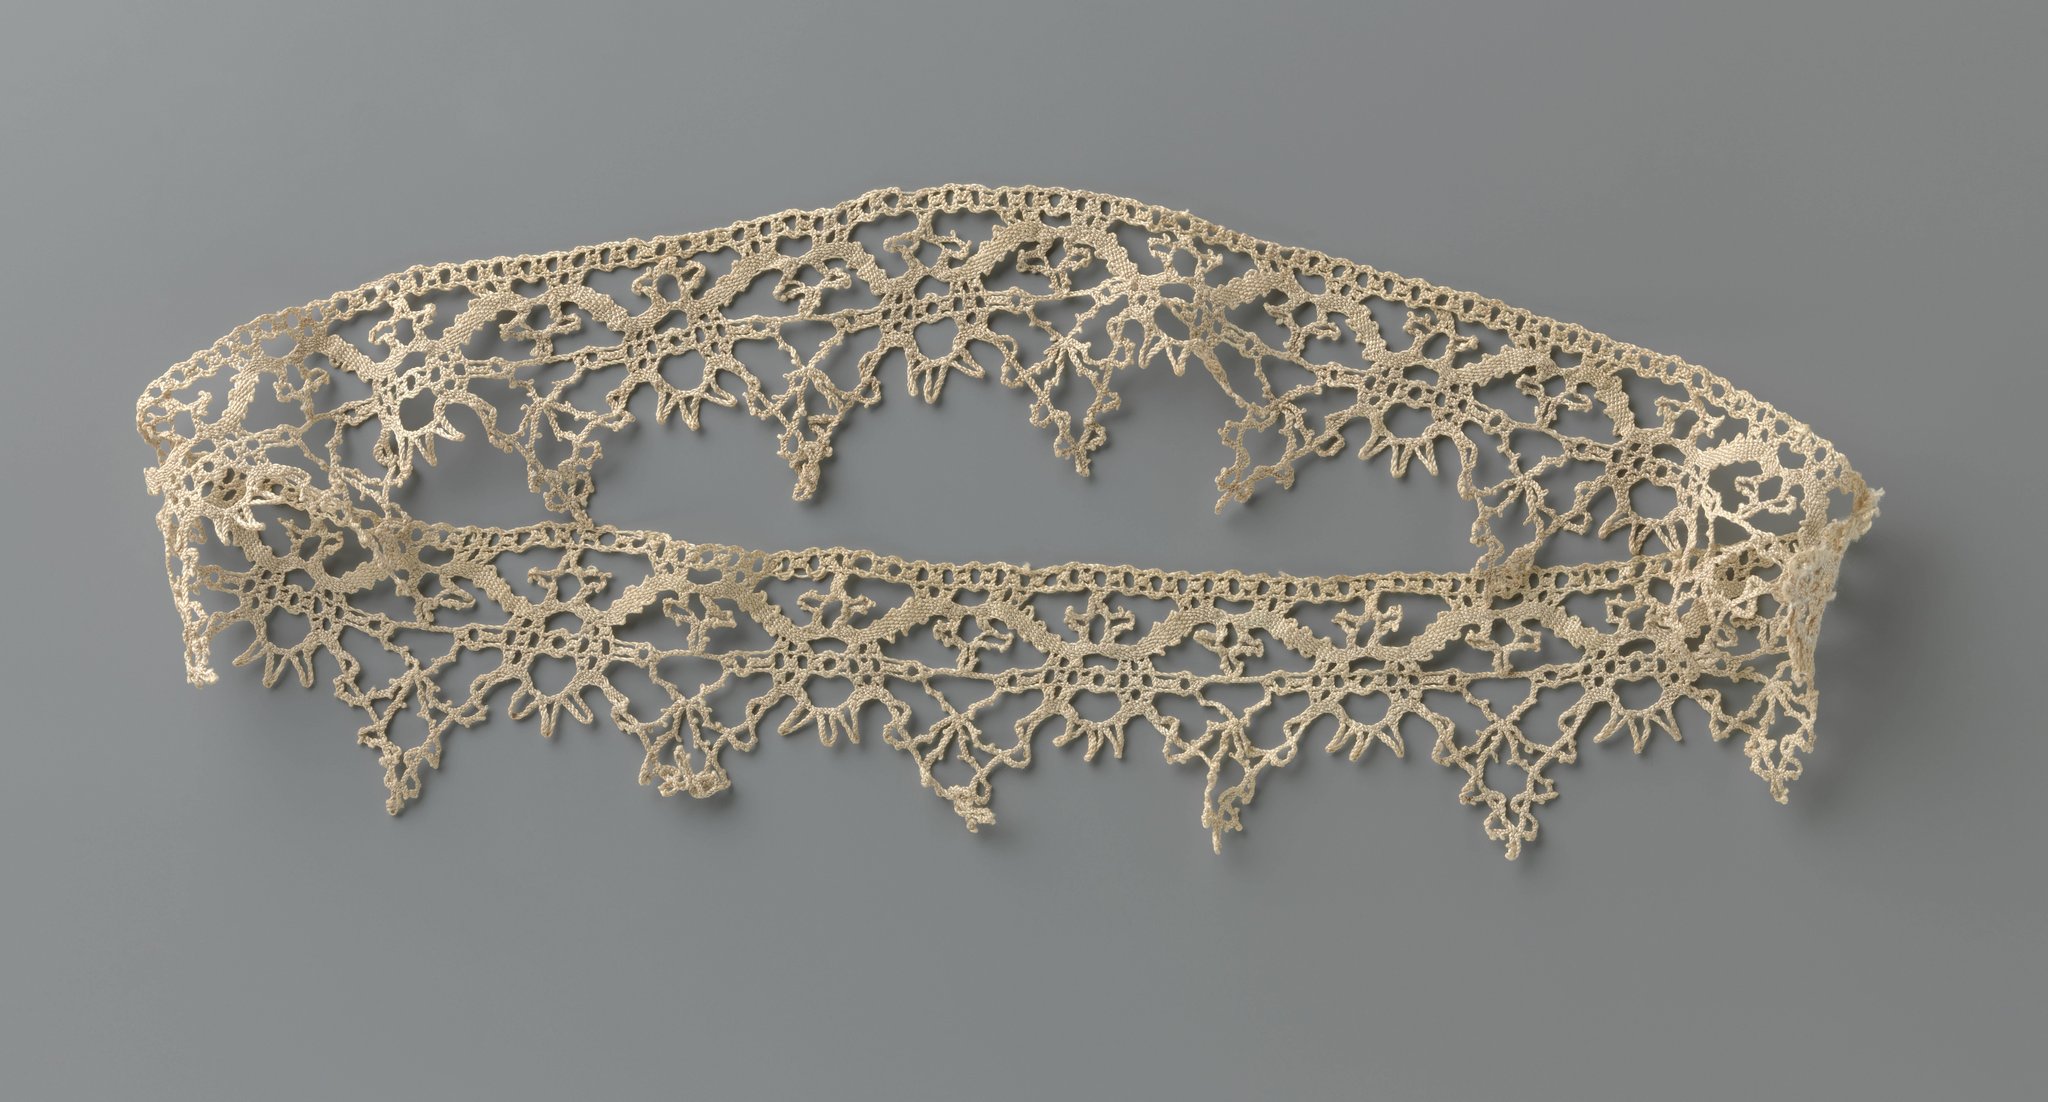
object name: strip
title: Strook kloskant met gevlochten puntschulpen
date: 1900-1924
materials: linen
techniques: lace, plaited lace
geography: berlin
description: Strook naturelkleurige Genuese kloskant, geklost naar voorbeeld van kant uit de eerste helft van de 17e eeuw. Het zich herhalende patroon bestaat uit een rechte baan waarin een golvende lijn loopt. Onder de rechte baan een schulpenrand met gevlochten puntschulpen. Met uitzondering van de golvende lijn die is gekost in linnenslag is het patroon vrijwel geheel opgebouwd uit vlechten. Bij de strook hoort een tekst: "Nach Vorlage einer alten Venetianischen Guipurespitse aus dem 17 Jahrhundert auf Bestelling geklöppelt in der Berliner Spitzenschule, Genthinerstrasse No. 7."